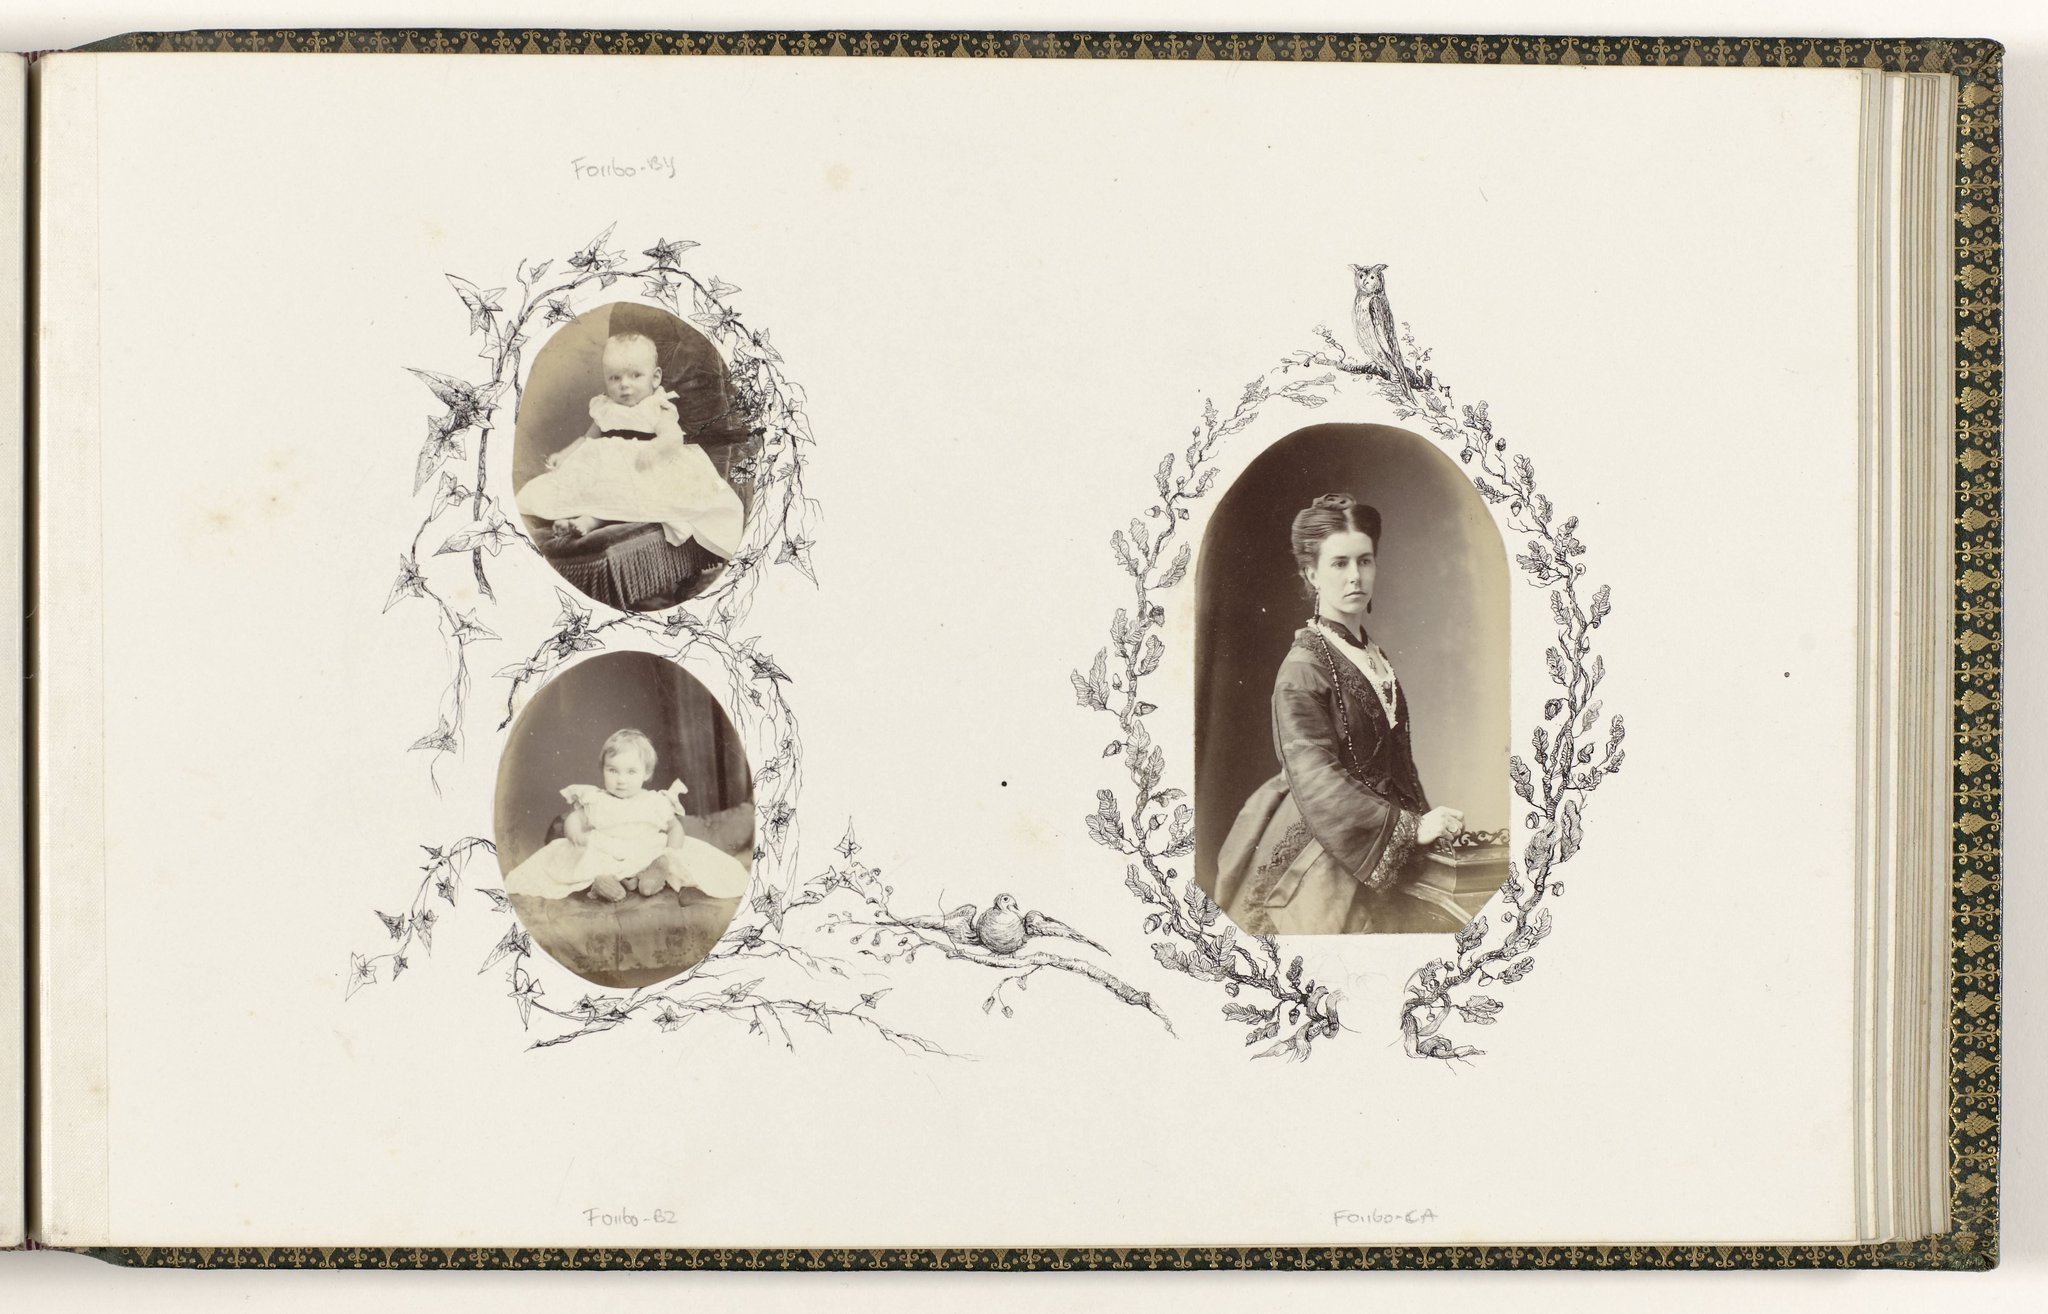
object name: photograph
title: Portret van een onbekend kind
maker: Anonymous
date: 1870-1880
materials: paper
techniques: albumen print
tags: historical persons, infant, baby